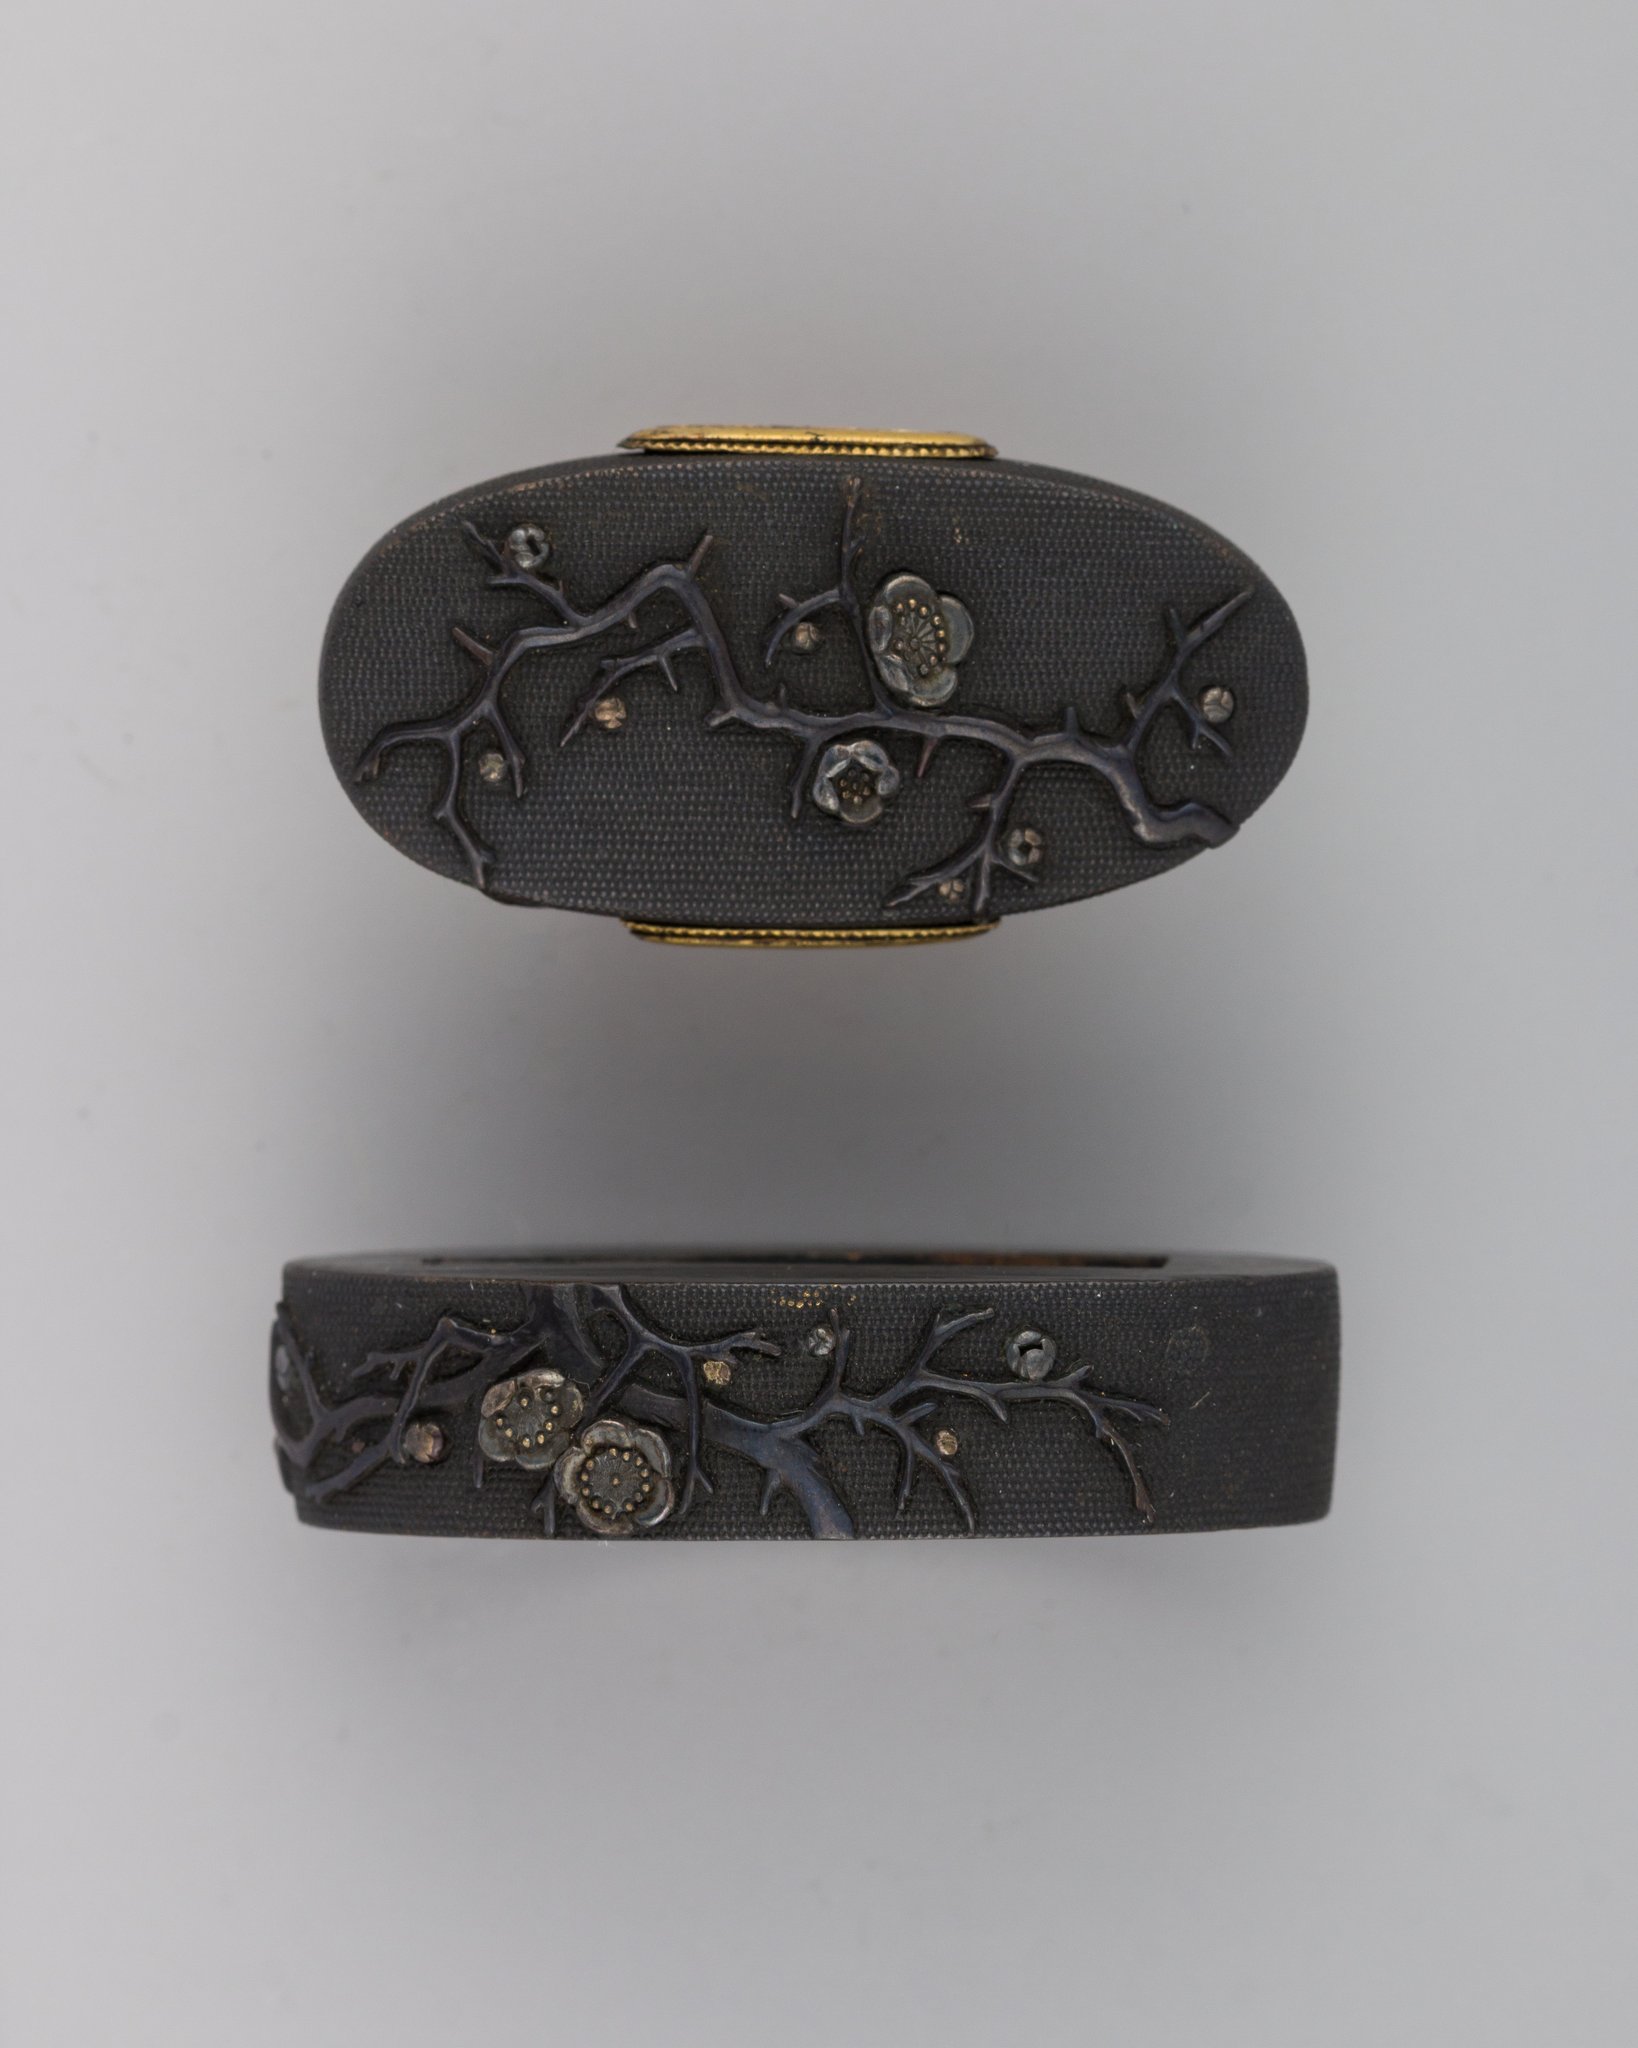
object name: sword hilt collar and pommel fuchigashira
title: Sword-Hilt Collar and Pommel (Fuchigashira)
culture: japanese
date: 1701-1900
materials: gold alloy, silver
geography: japan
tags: flowers